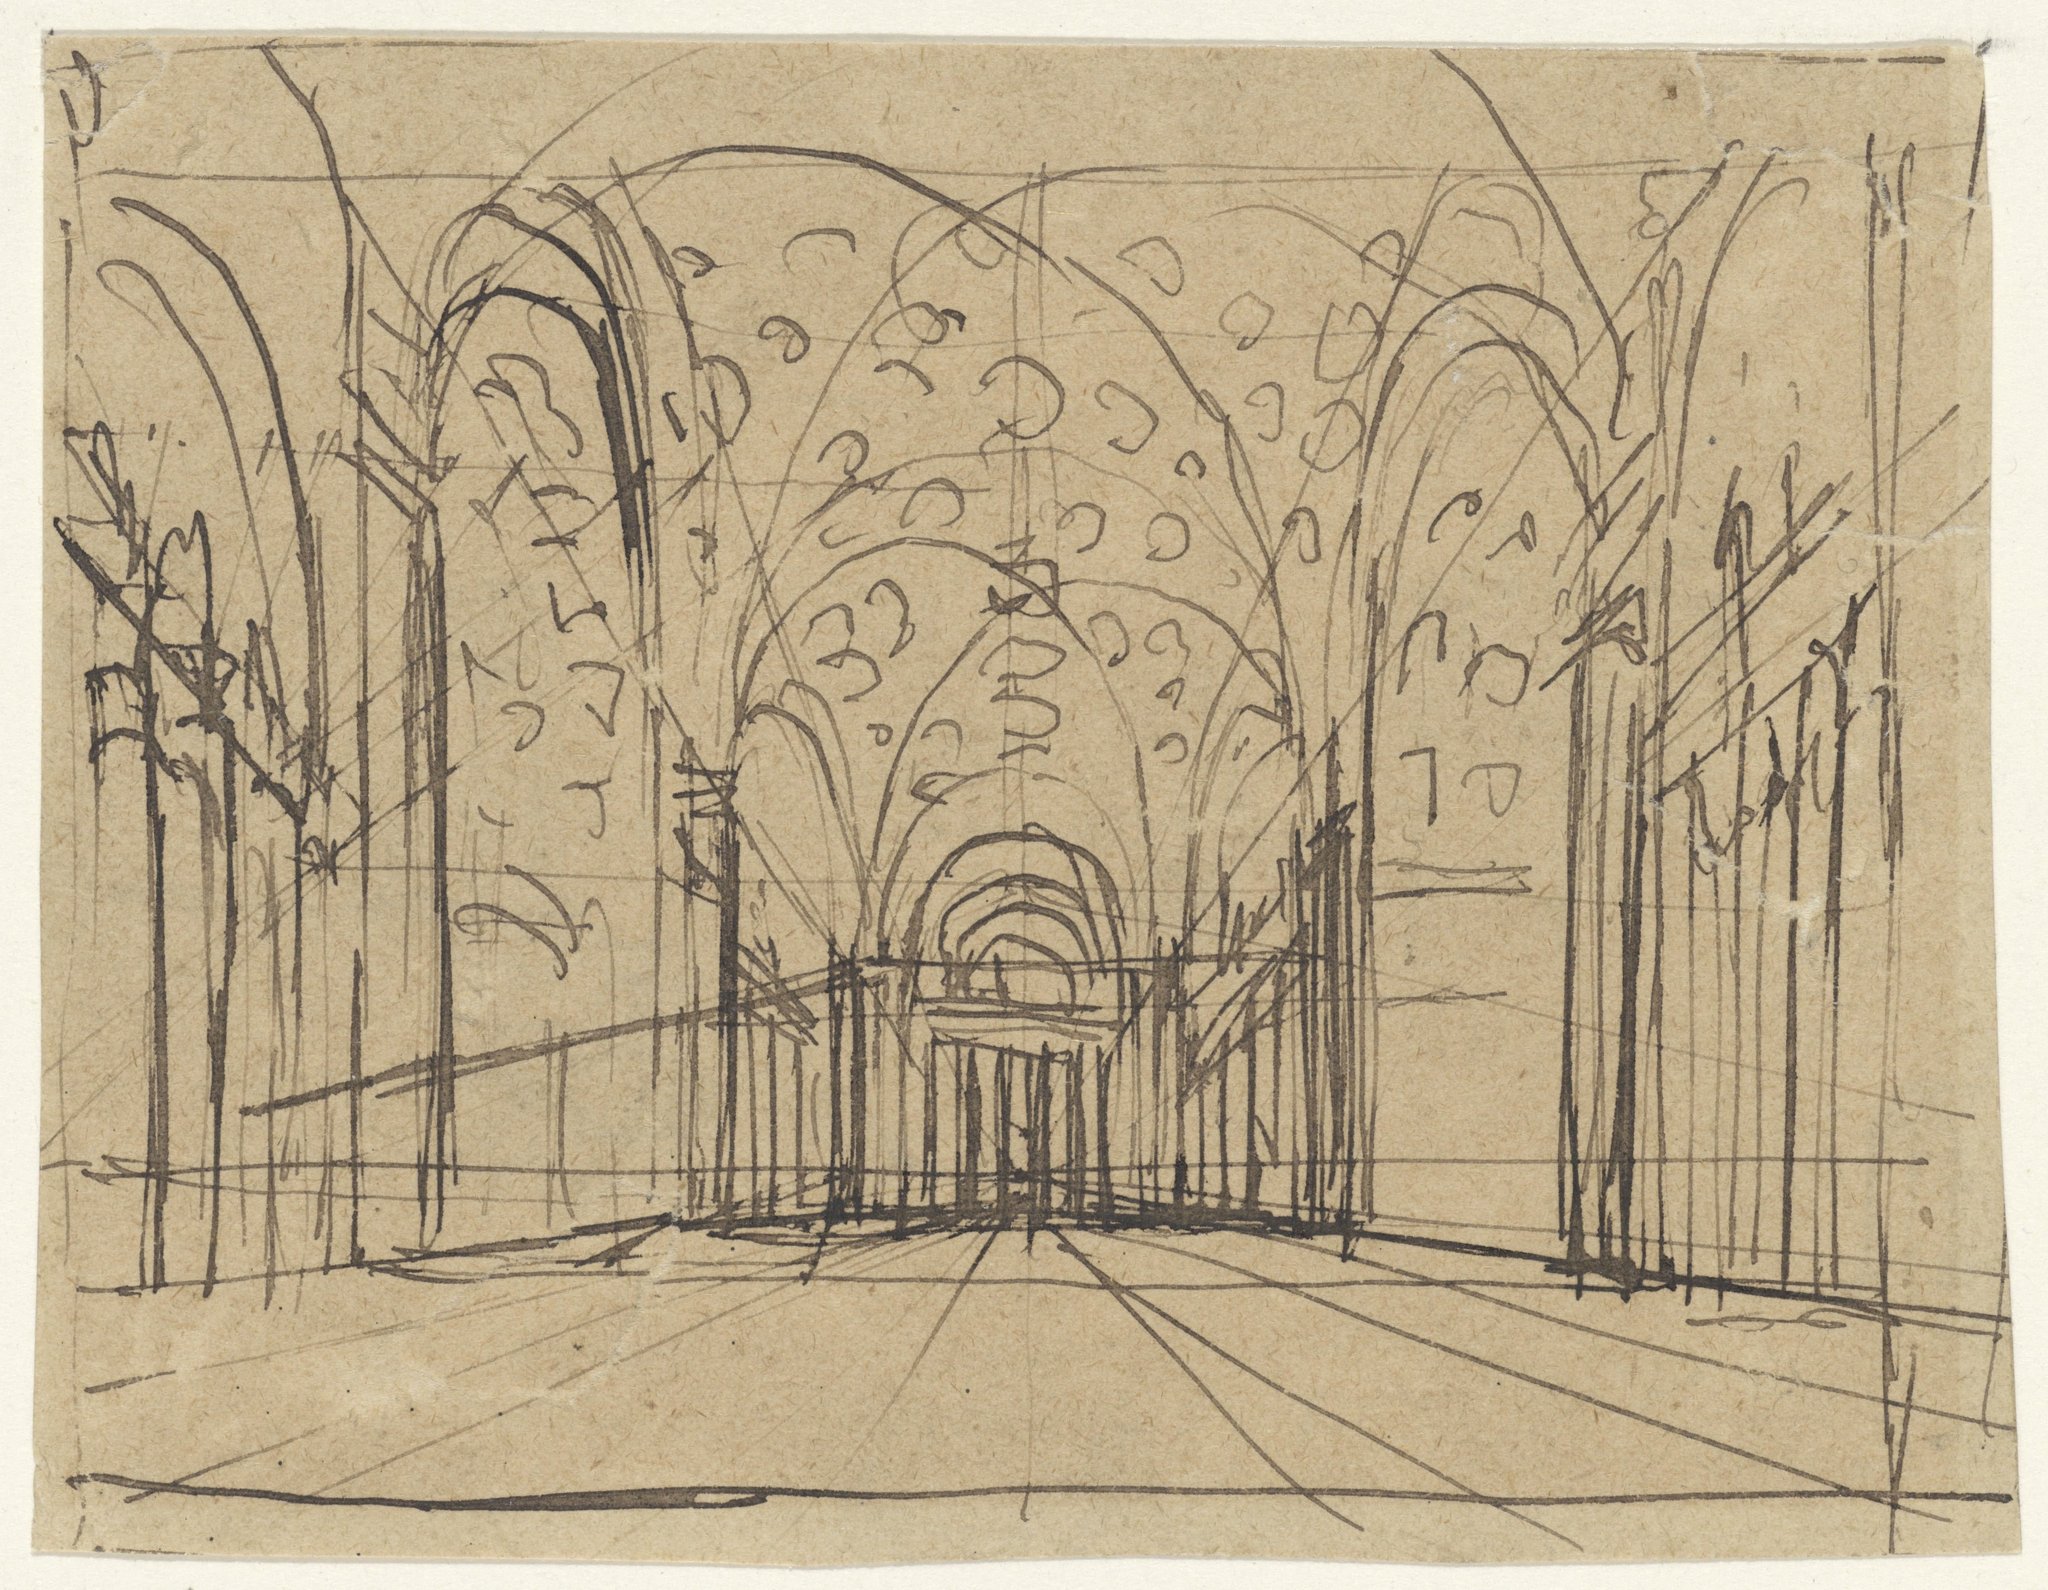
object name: drawing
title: Kerkinterieur te Rome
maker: thomas cool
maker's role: draughtsman, painter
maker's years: 1851-1904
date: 1861-1904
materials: ink, paper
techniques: pen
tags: interior of church, rome